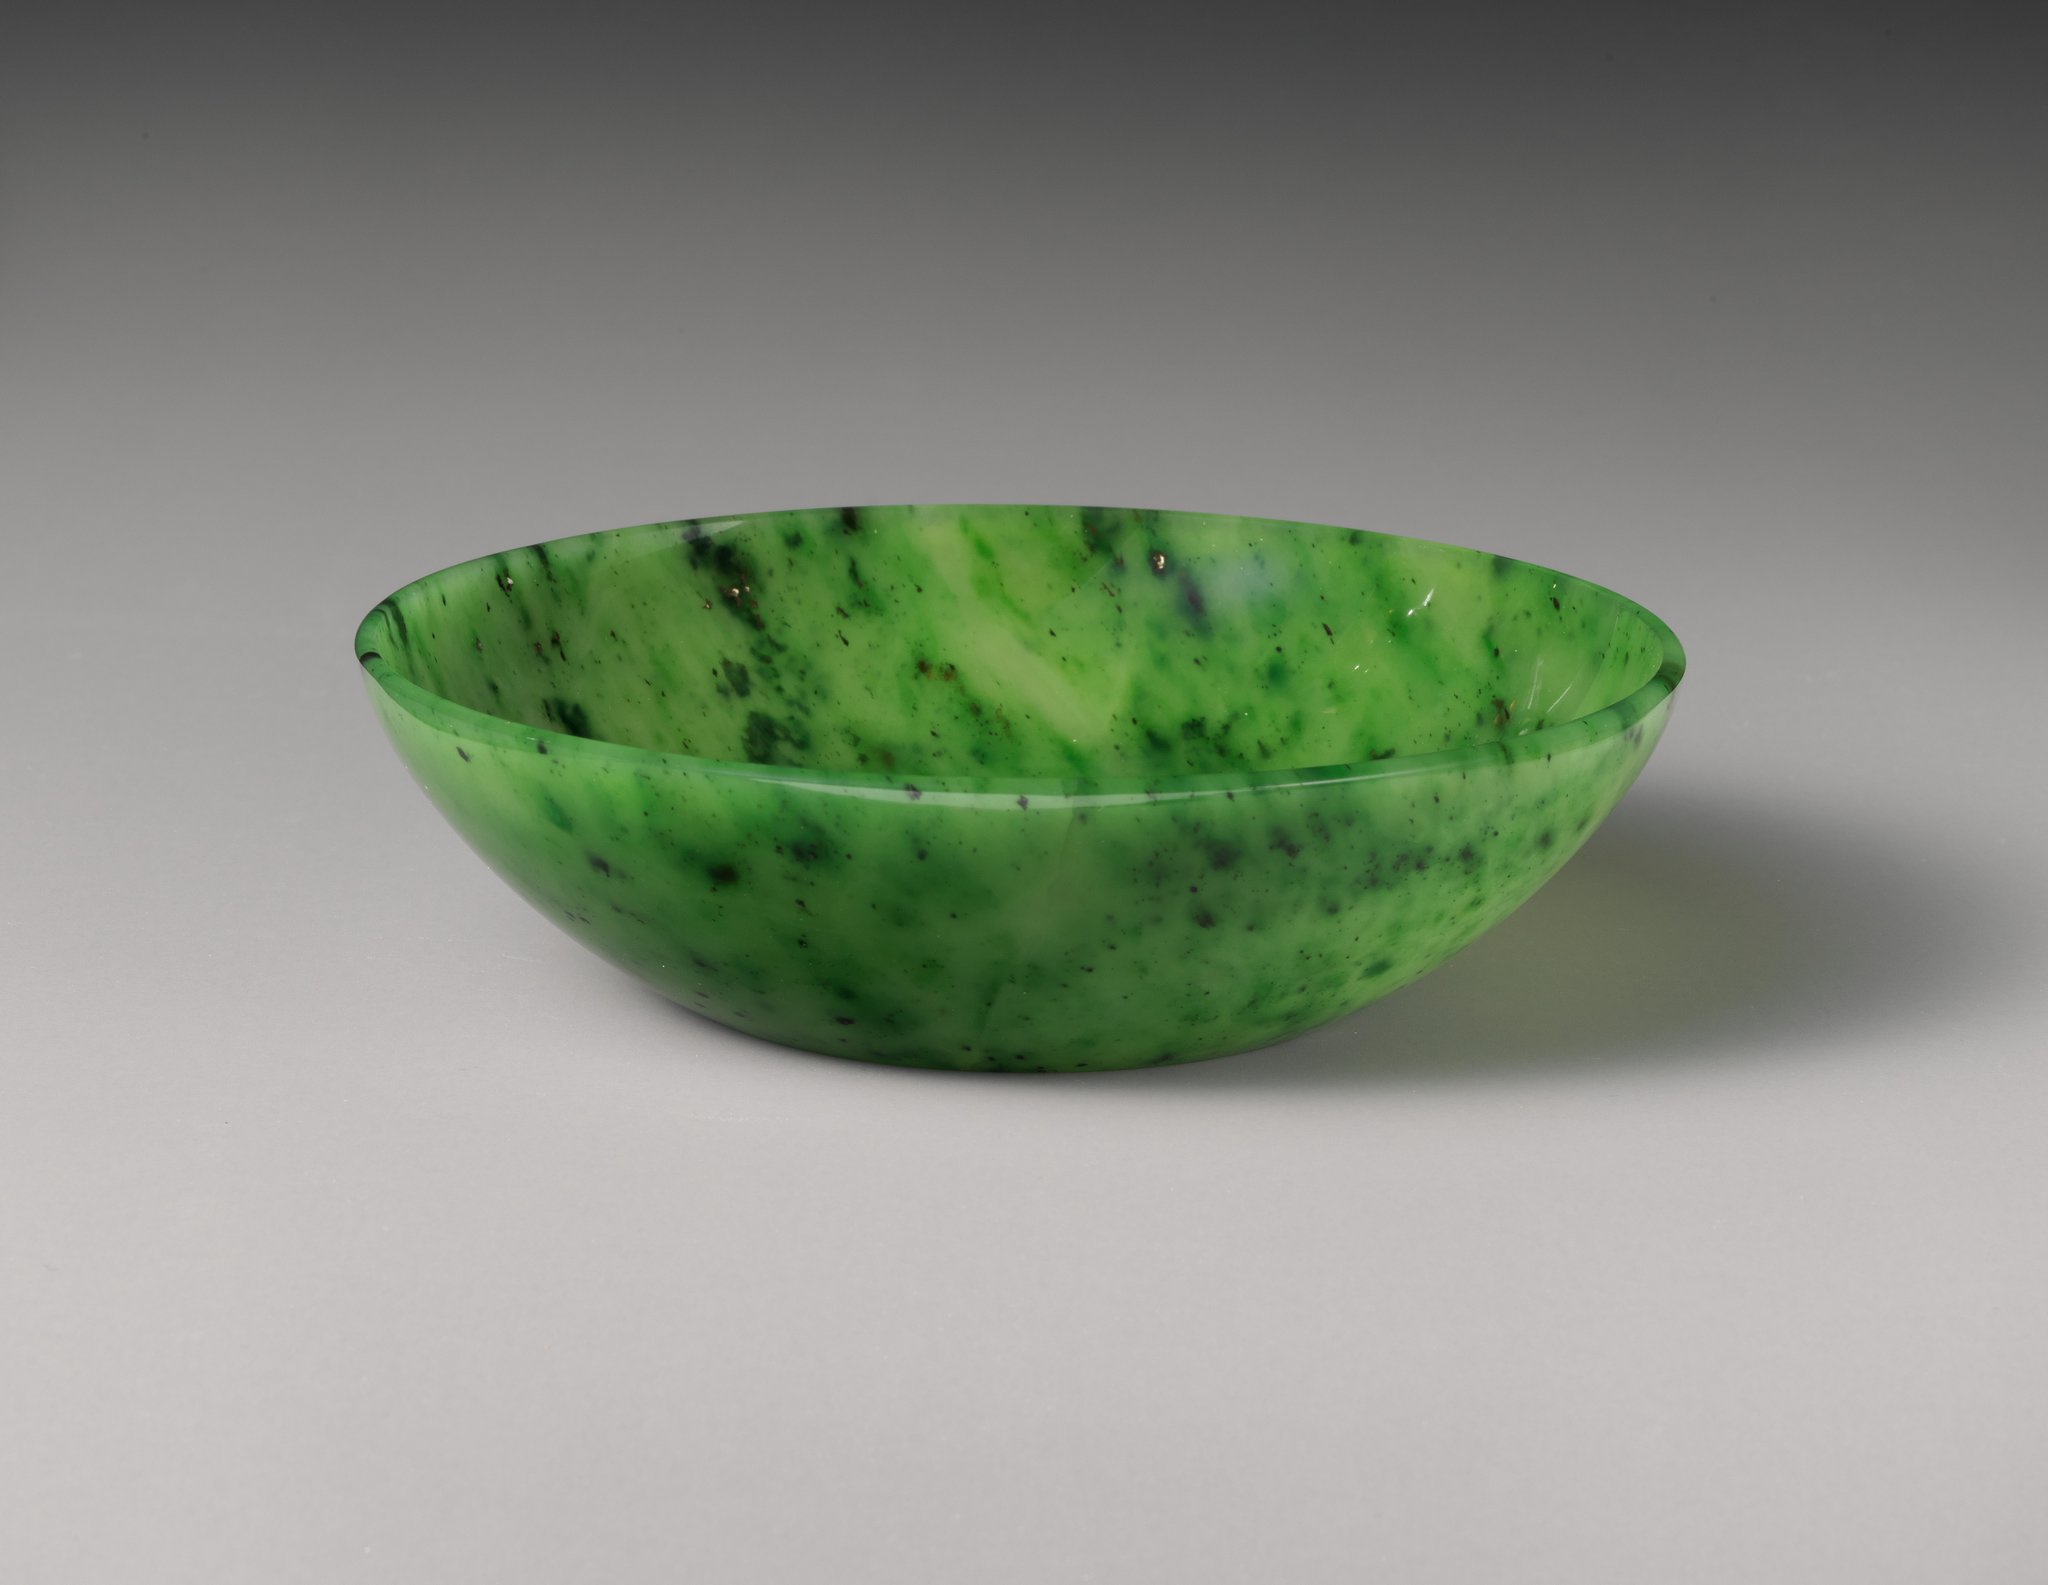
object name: bowl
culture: russian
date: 1883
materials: jade